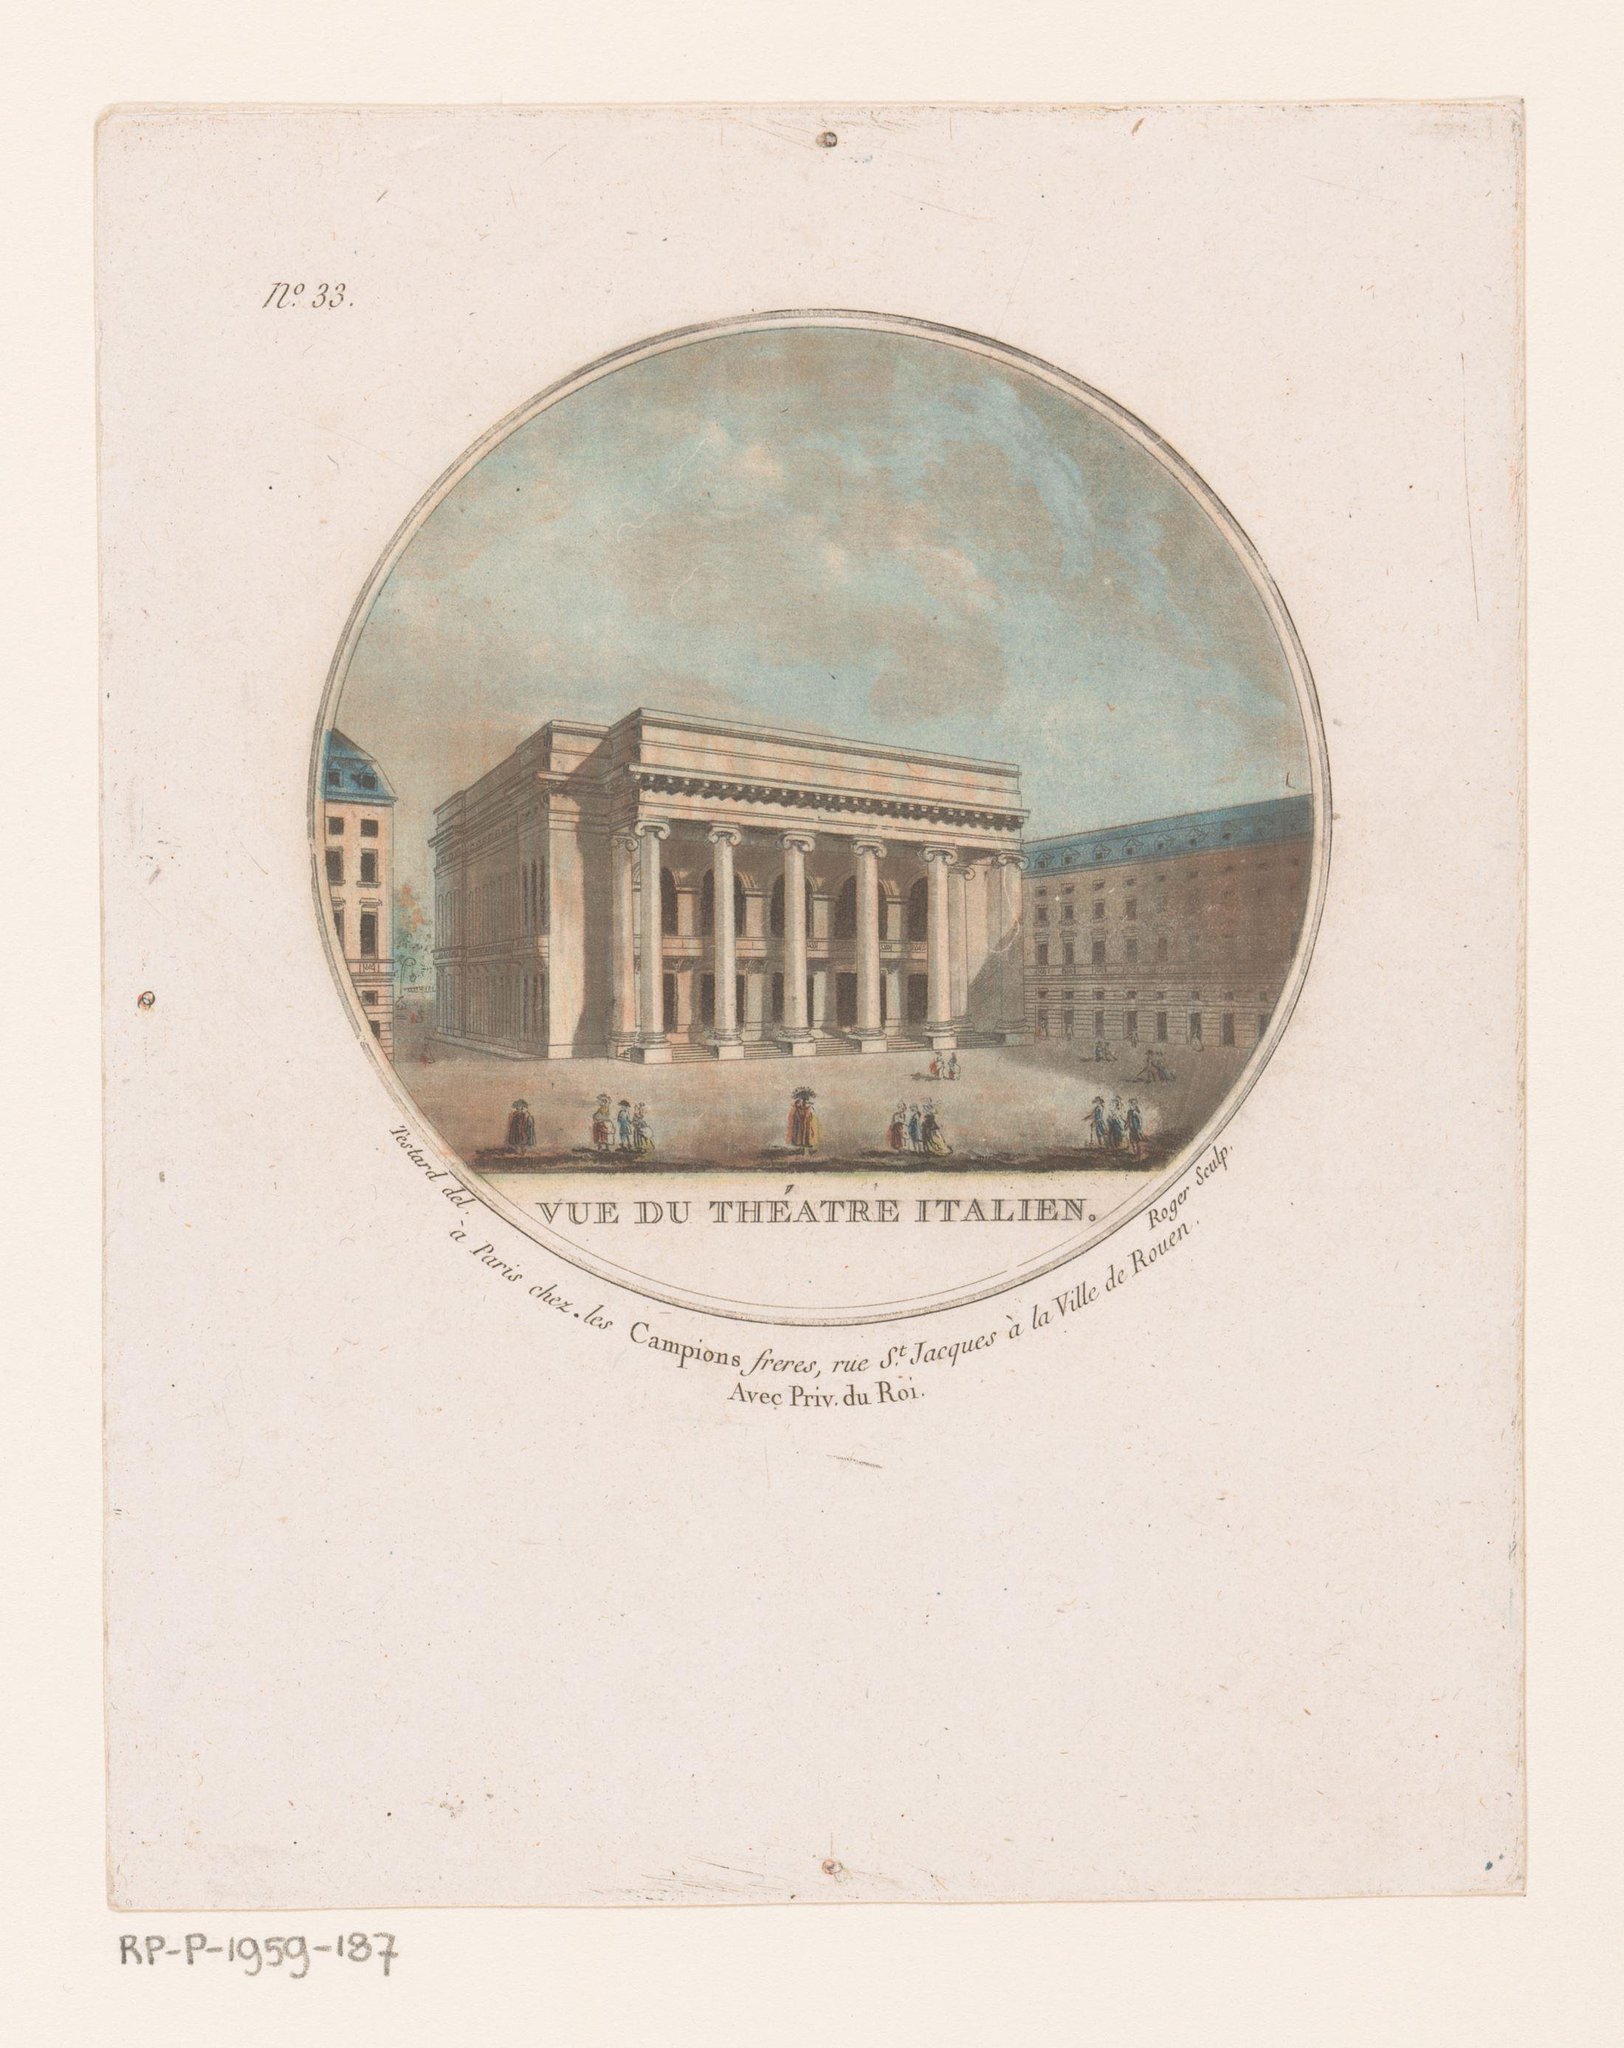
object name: print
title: Vue du théatre Italien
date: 1789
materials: paper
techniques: aquatint, etching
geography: france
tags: city-view in general; 'veduta', theatre (building), paris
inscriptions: collector's mark: Lugt 2228, collector's mark: Lugt 2760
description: Prent maakt deel uit van een serie van 110 cirkelvormige aquatinten door Le Campion, Guyot, Roger, Guillot, Belley en Mlle Guyot naar F.M. Testard en Sergent.